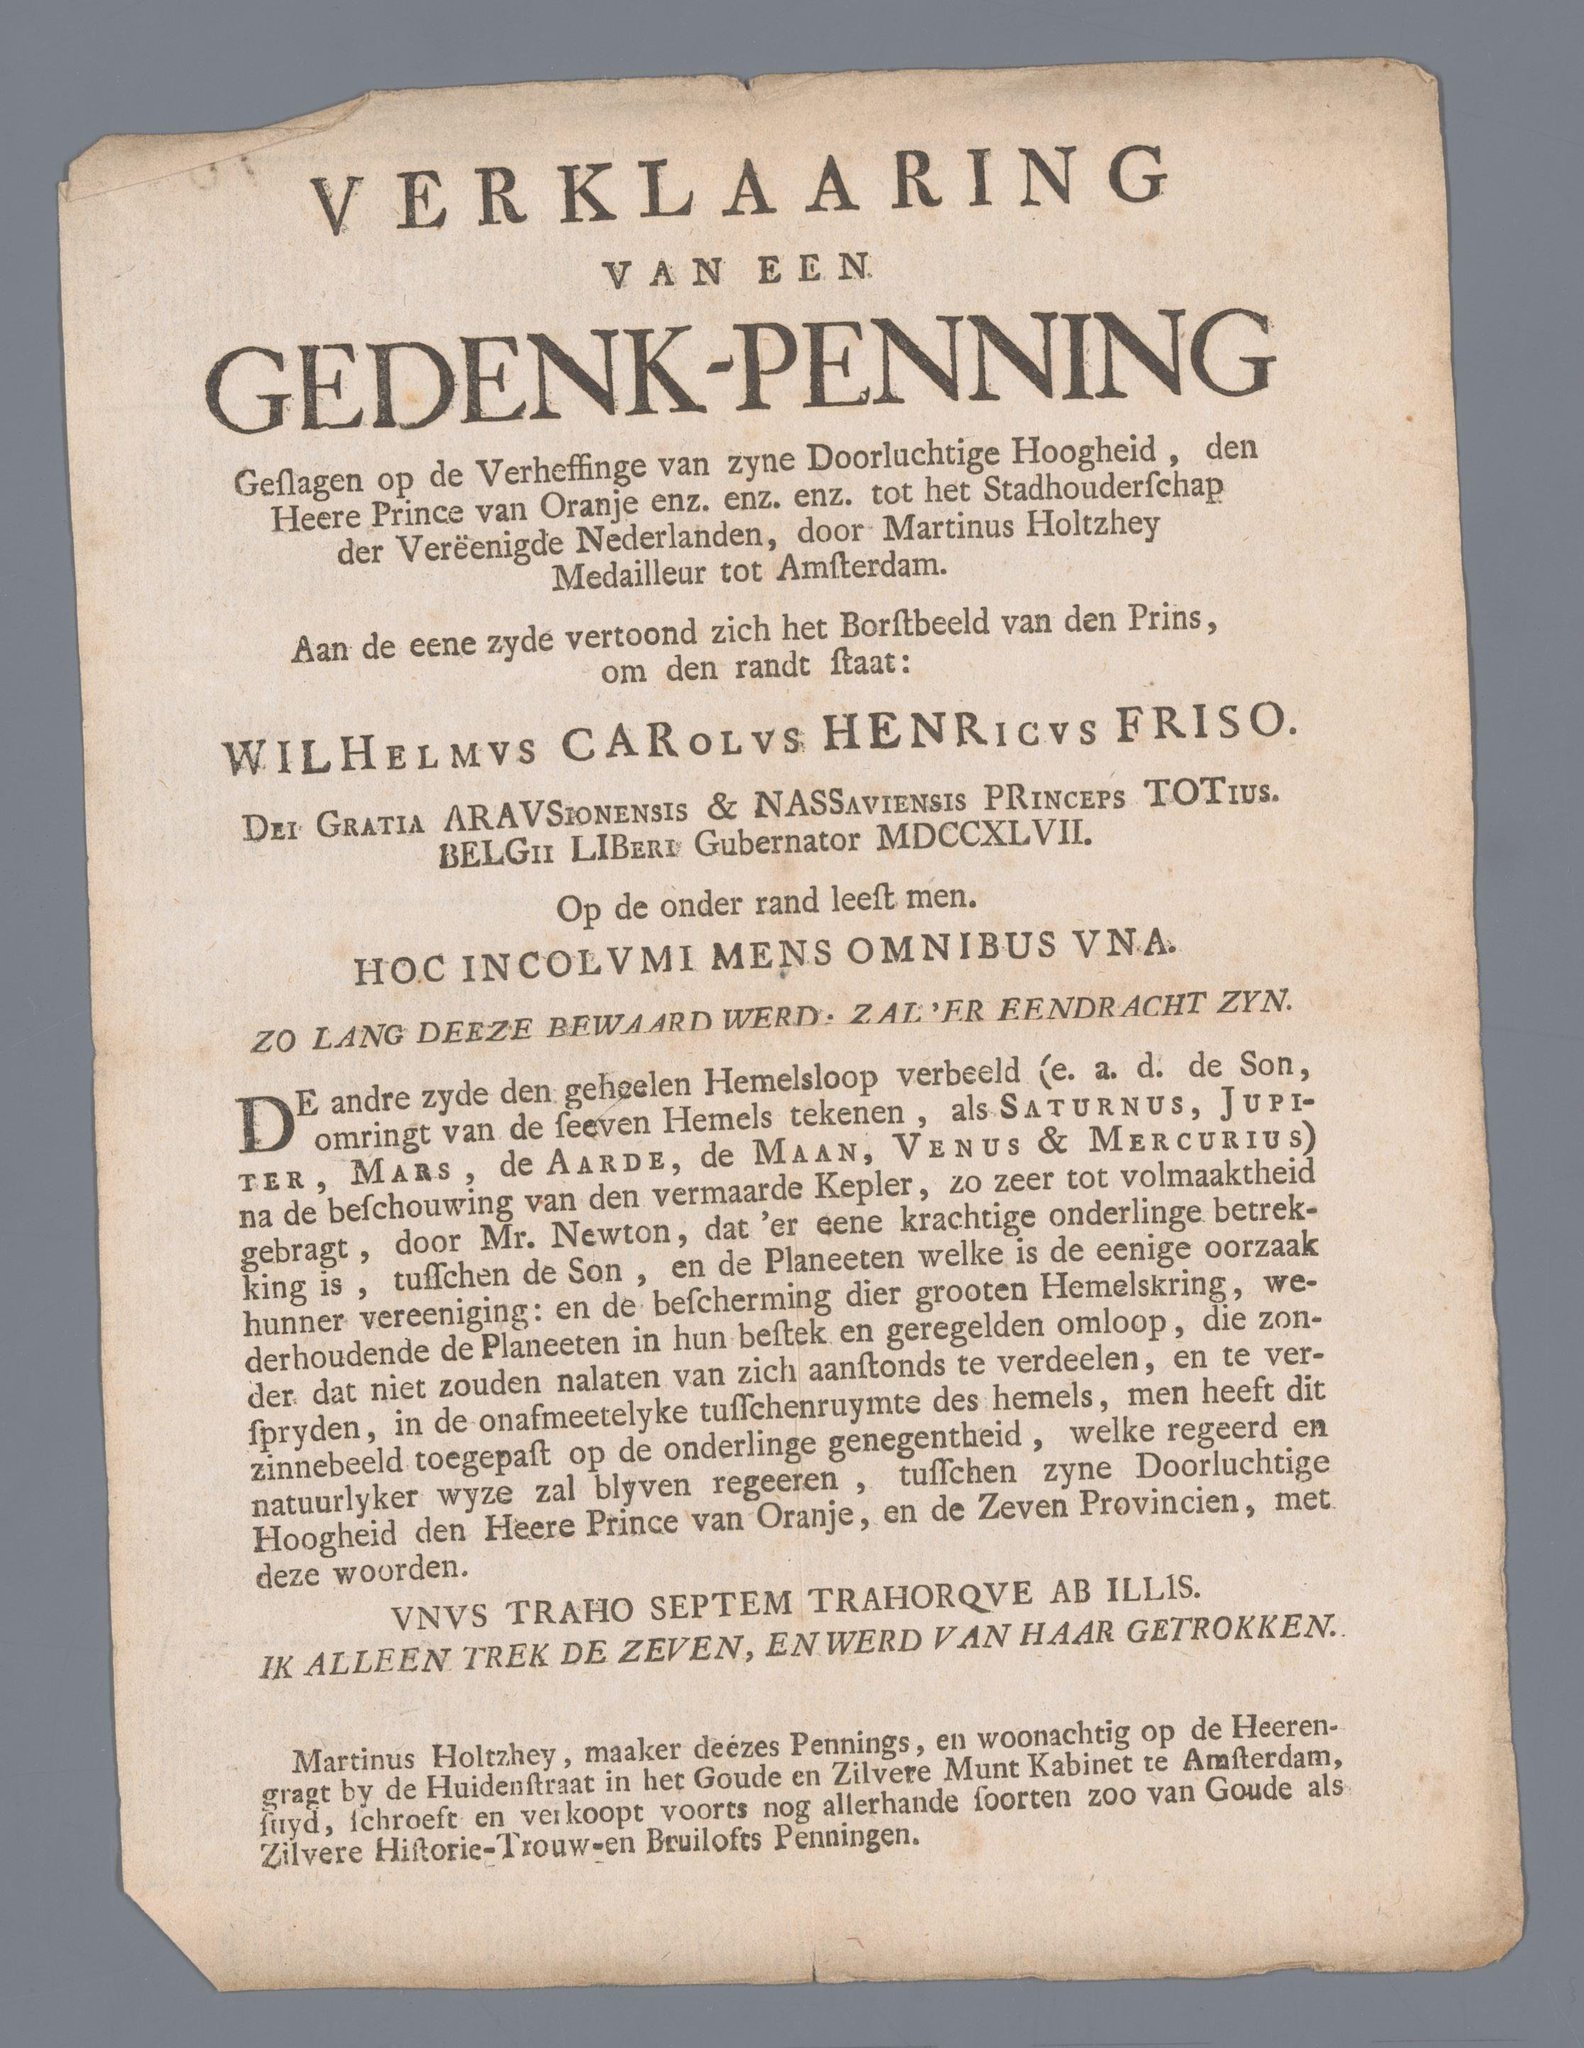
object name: pamphlet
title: Verklaring van de penning door Martinus Holtzhey geslagen op de inhuldiging van Willem IV, prins van Oranje-Nassau, als erfelijk stadhouder van de Nederlanden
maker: Anonymous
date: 1747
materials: paper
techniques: printing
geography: amsterdam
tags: willem iv (prins van oranje-nassau)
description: Eenzijdig, rechthoekig papier met opschrift, gedrukt in zwarte inkt. Keerzijde: cijfer 16 in zwarte inkt geschreven.